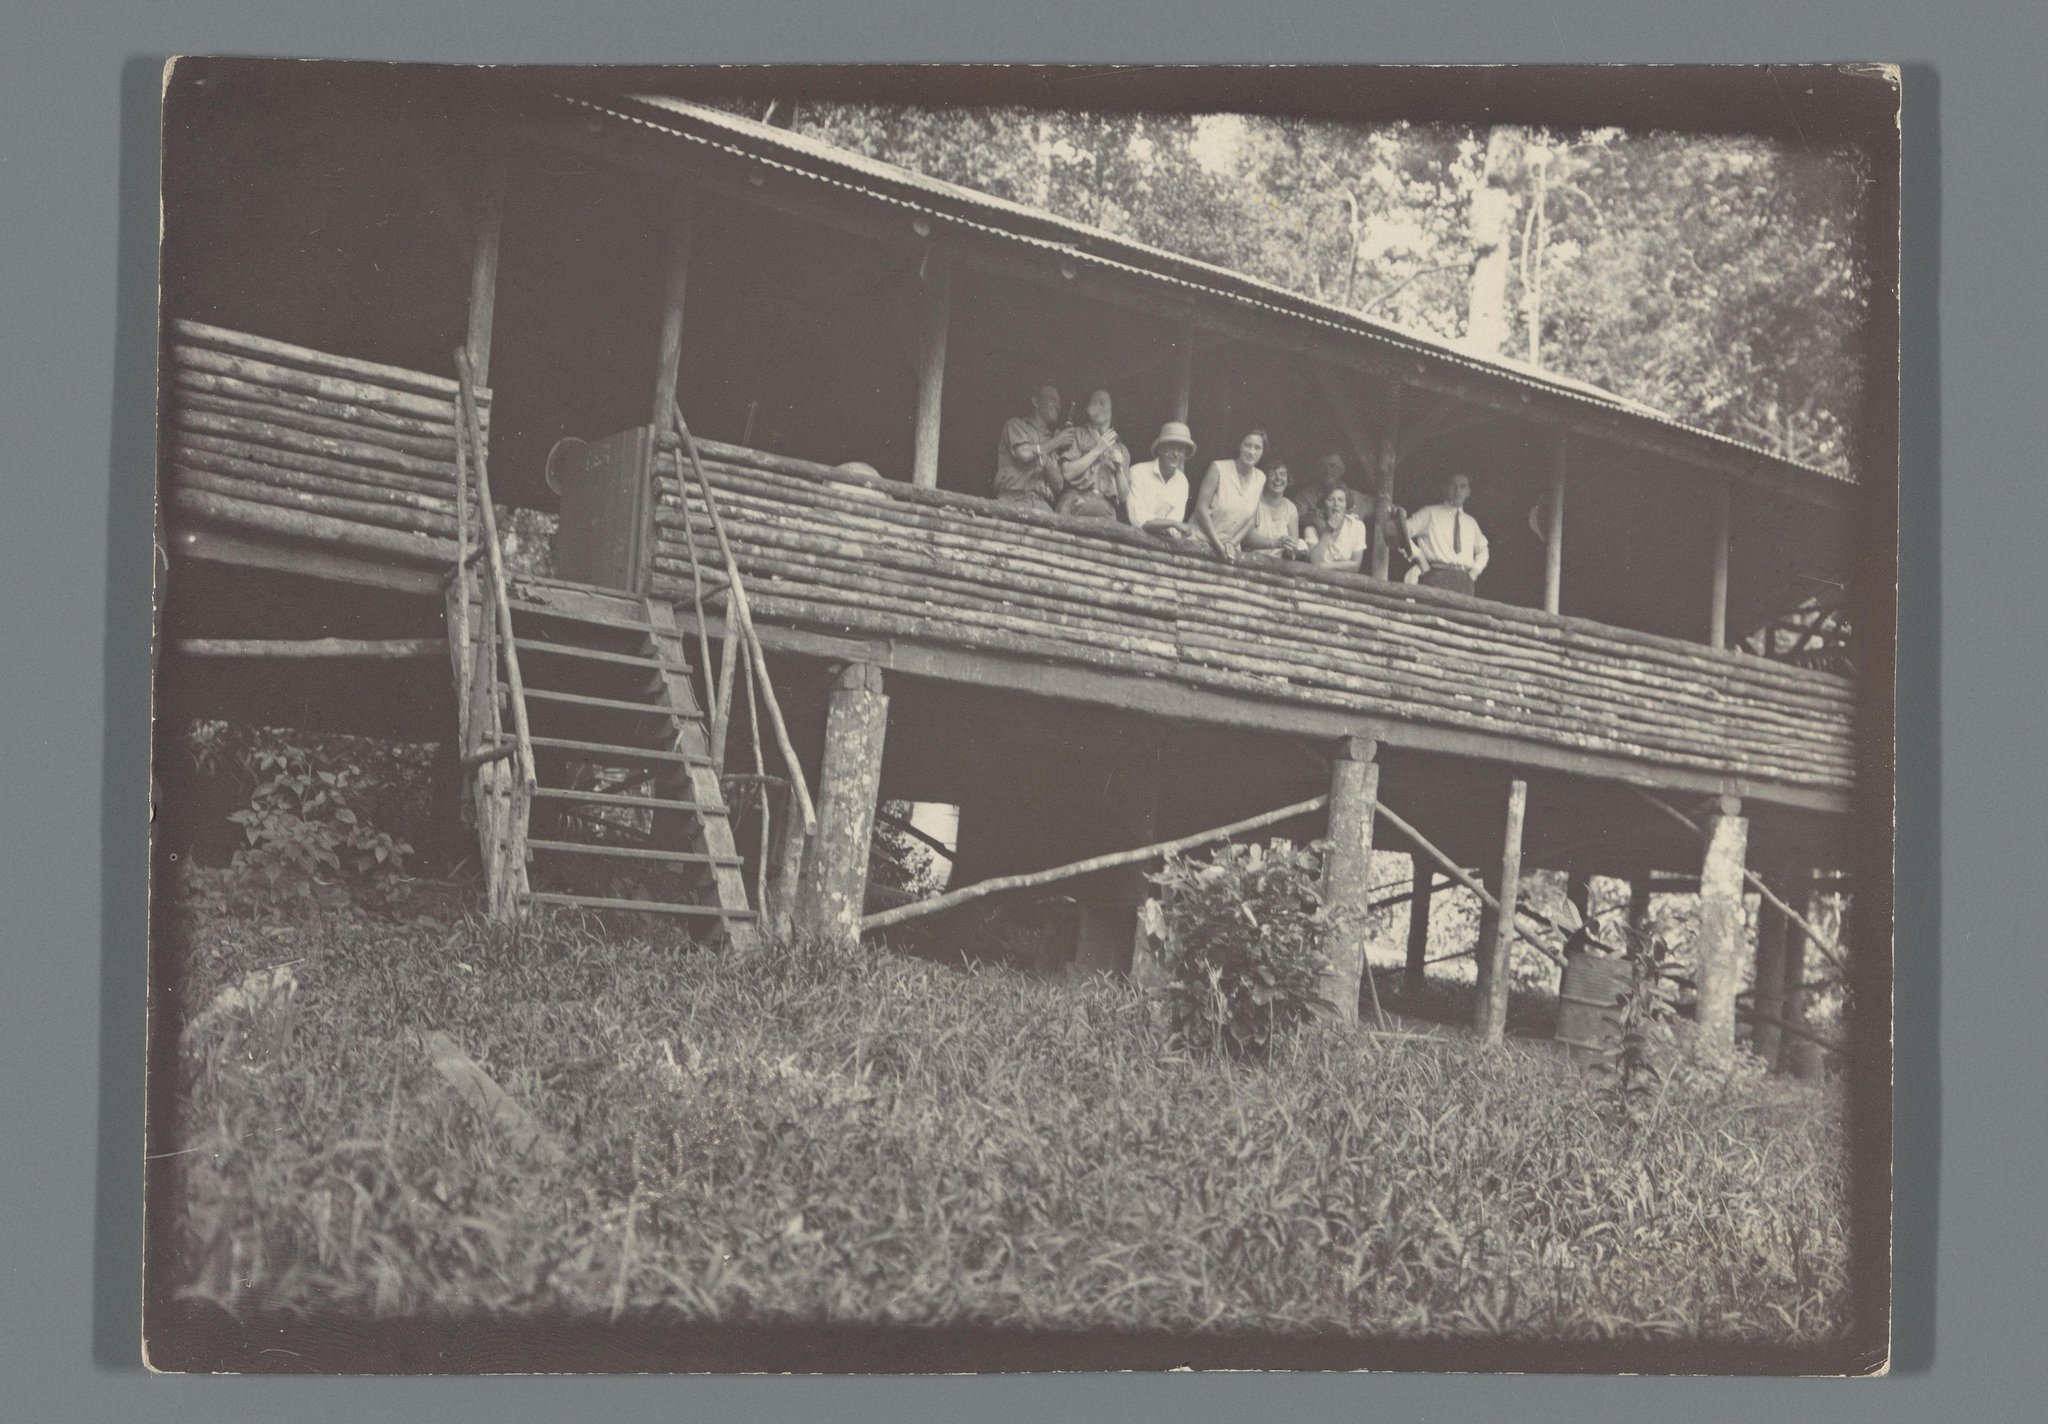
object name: photograph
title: Echtpaar Jetten in houten gebouw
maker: Anonymous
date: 1925-1927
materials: photographic support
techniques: photography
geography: suriname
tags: jetten, familie, moengo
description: Een groep Nederlanders, waaronder het echtpaar Jetten, uitkijkend uit een houten gebouw. Onderdeel van het ensemble met foto's van de familie van ingenieur Jetten in de mijnbouwstad Moengo in Suriname.